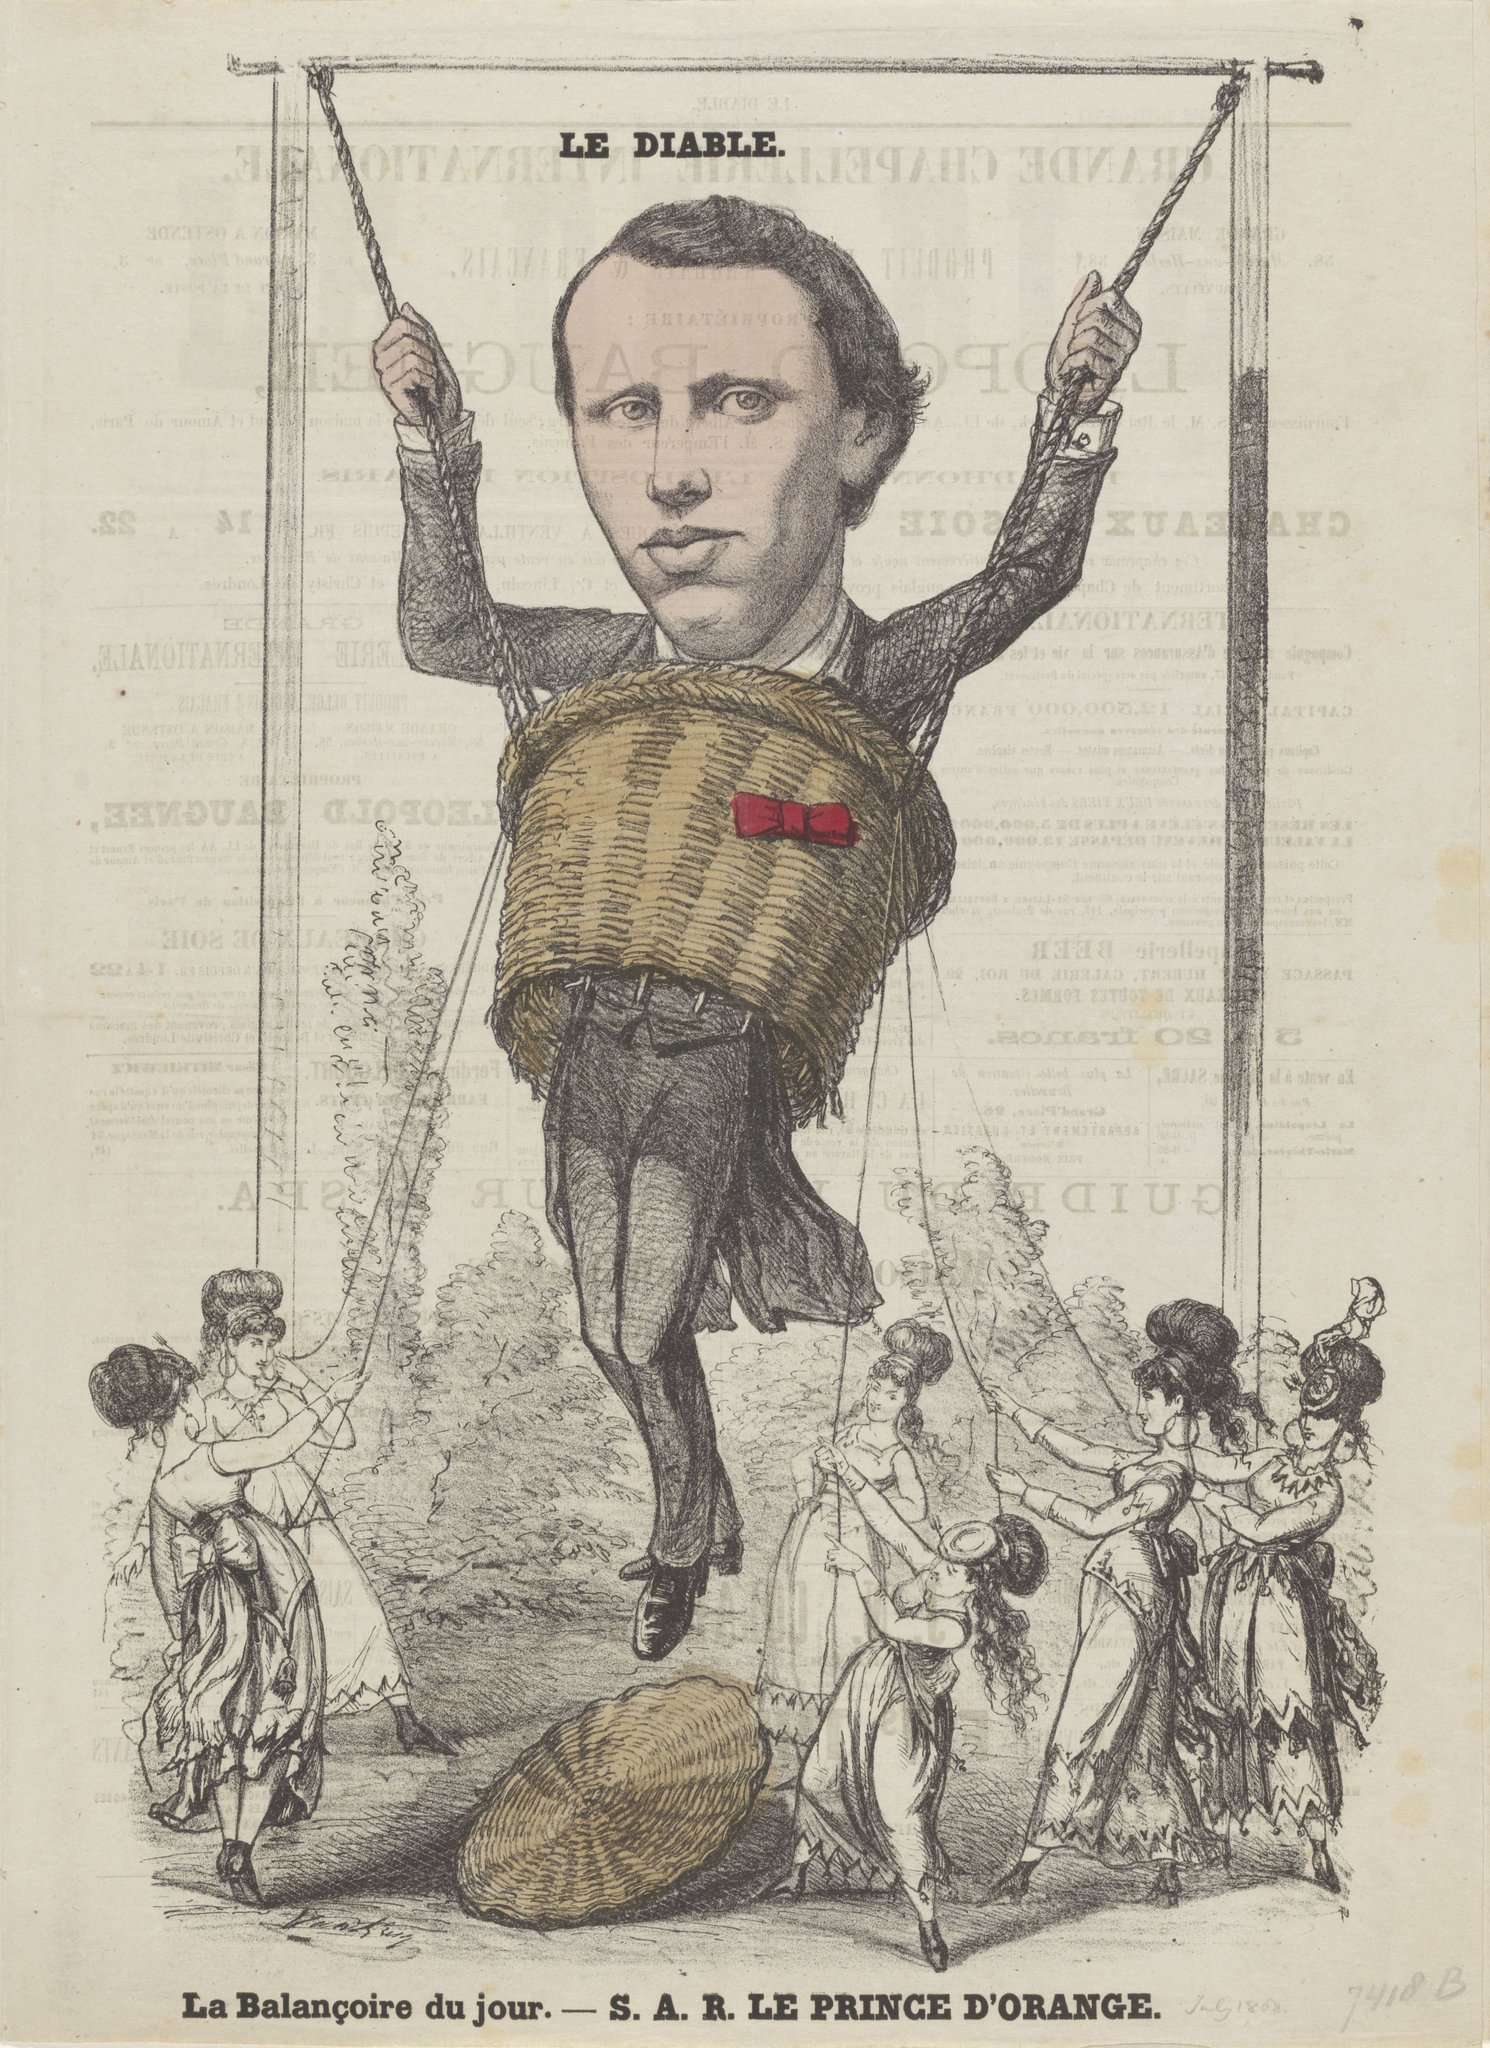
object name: newspaper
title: Spotprent op prins Willem, 1868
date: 1868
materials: paper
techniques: hand coloring, lithograph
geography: brussels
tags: the hague, willem (prins der nederlanden), swinging (children's game), swing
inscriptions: collector's mark: Lugt 2228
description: Spotprent op Prins Willem in de Brusselse krant 'Le Diable' van 19 juli 1868. De prins is door de bodem gezakt van een mand aan een schommel en wordt door jonge vrouwen (balleteuses) heen en weer getrokken. Dubbelgevouwen blad bedrukt op alle zijden.